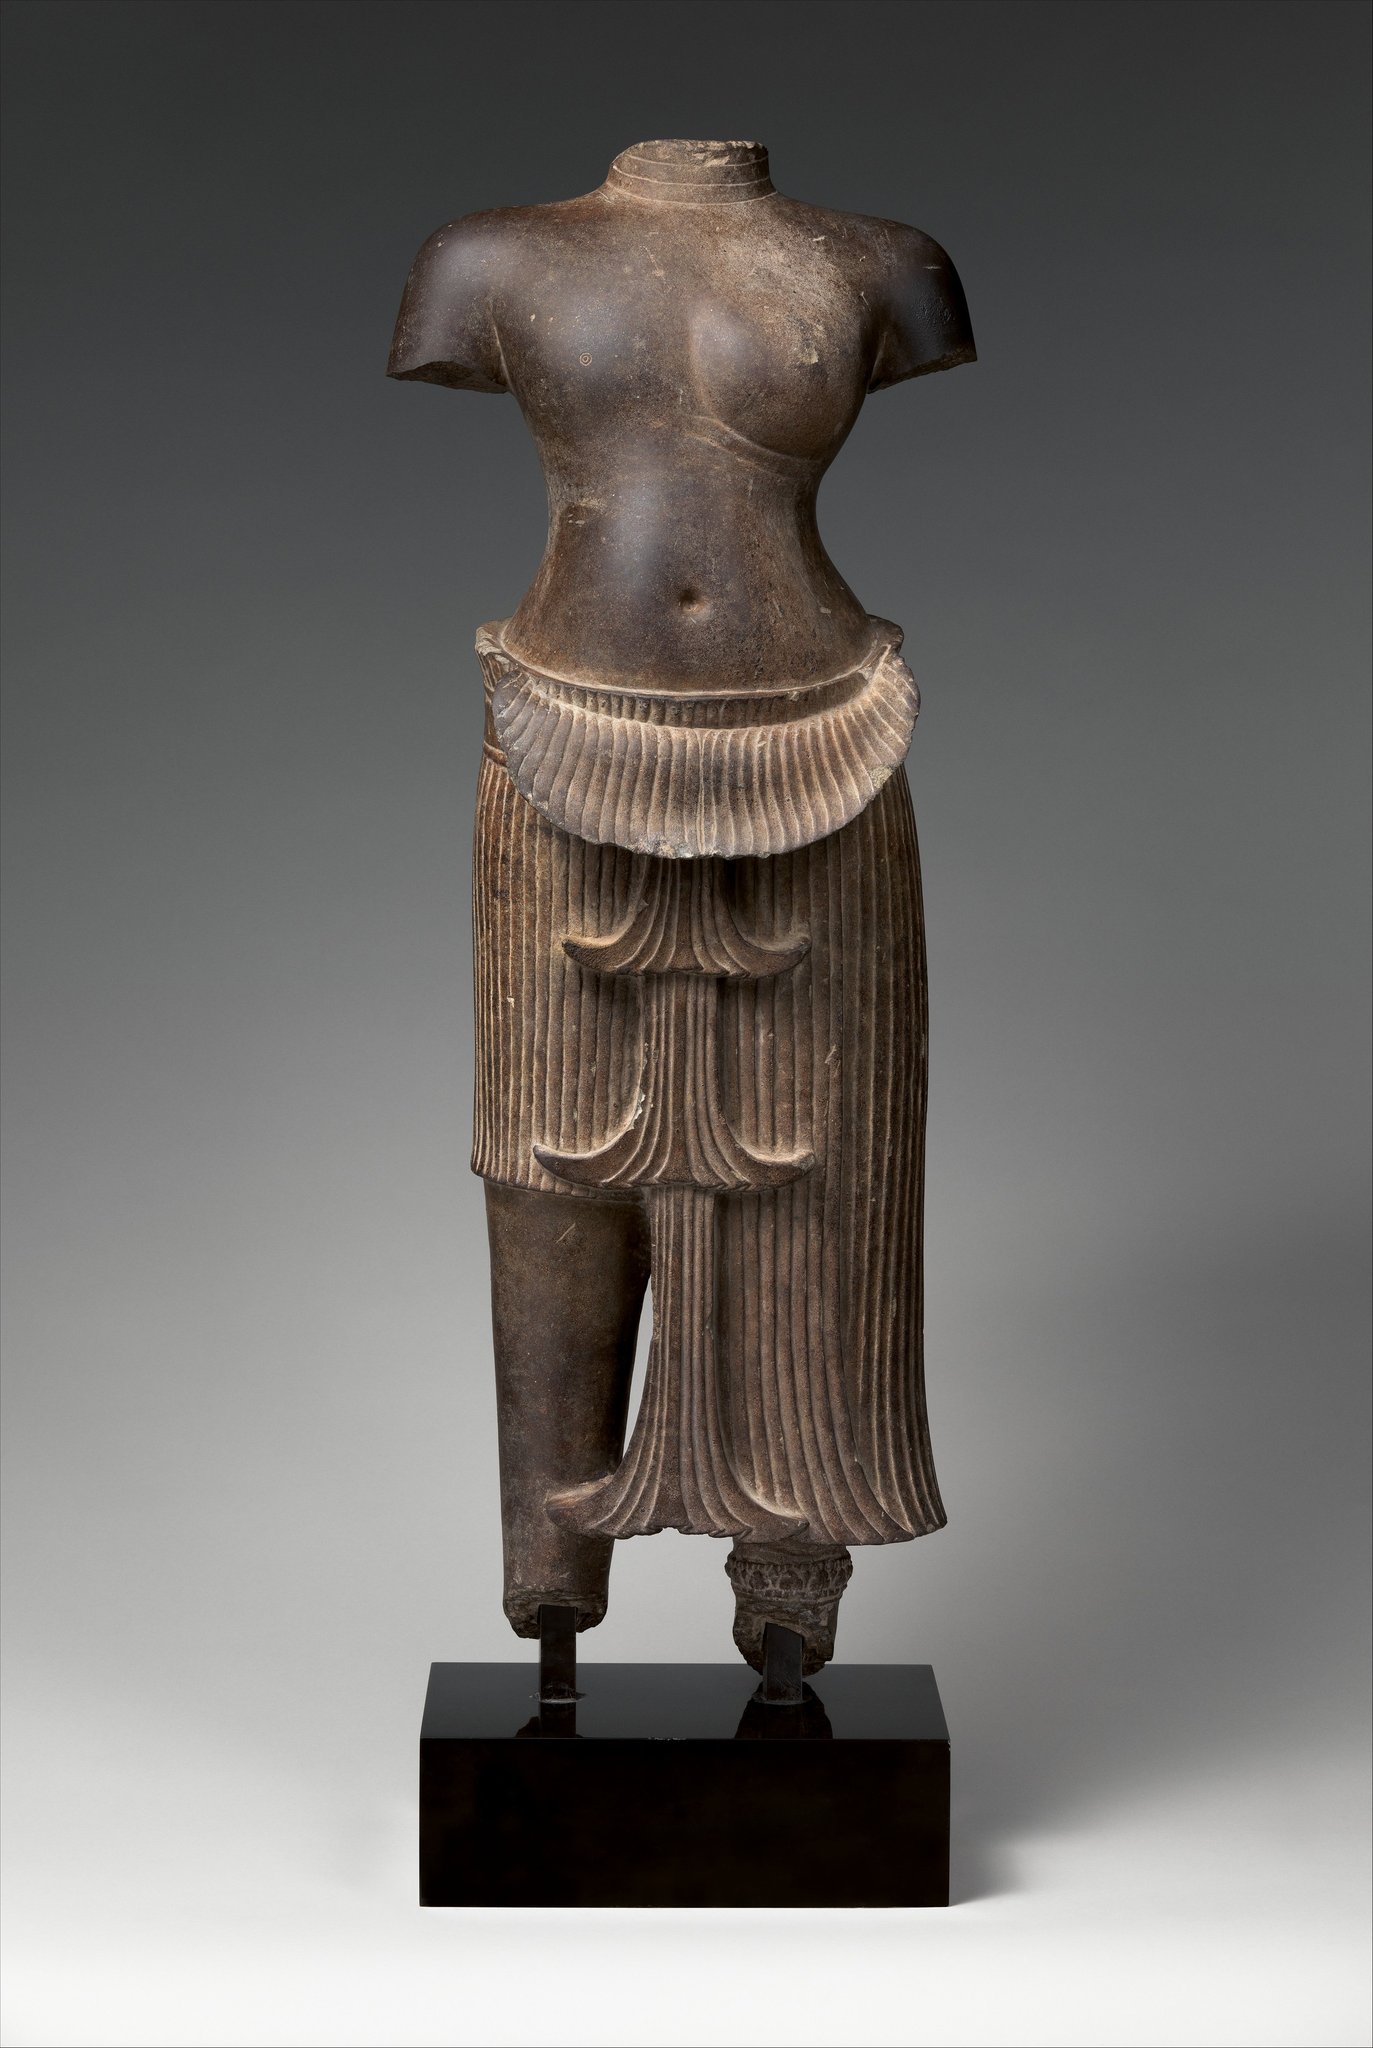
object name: figure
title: The Half-Male, Half-Female Form of Shiva (Shiva Ardhanarishvara)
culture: cambodian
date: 921-945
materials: stone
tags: shiva